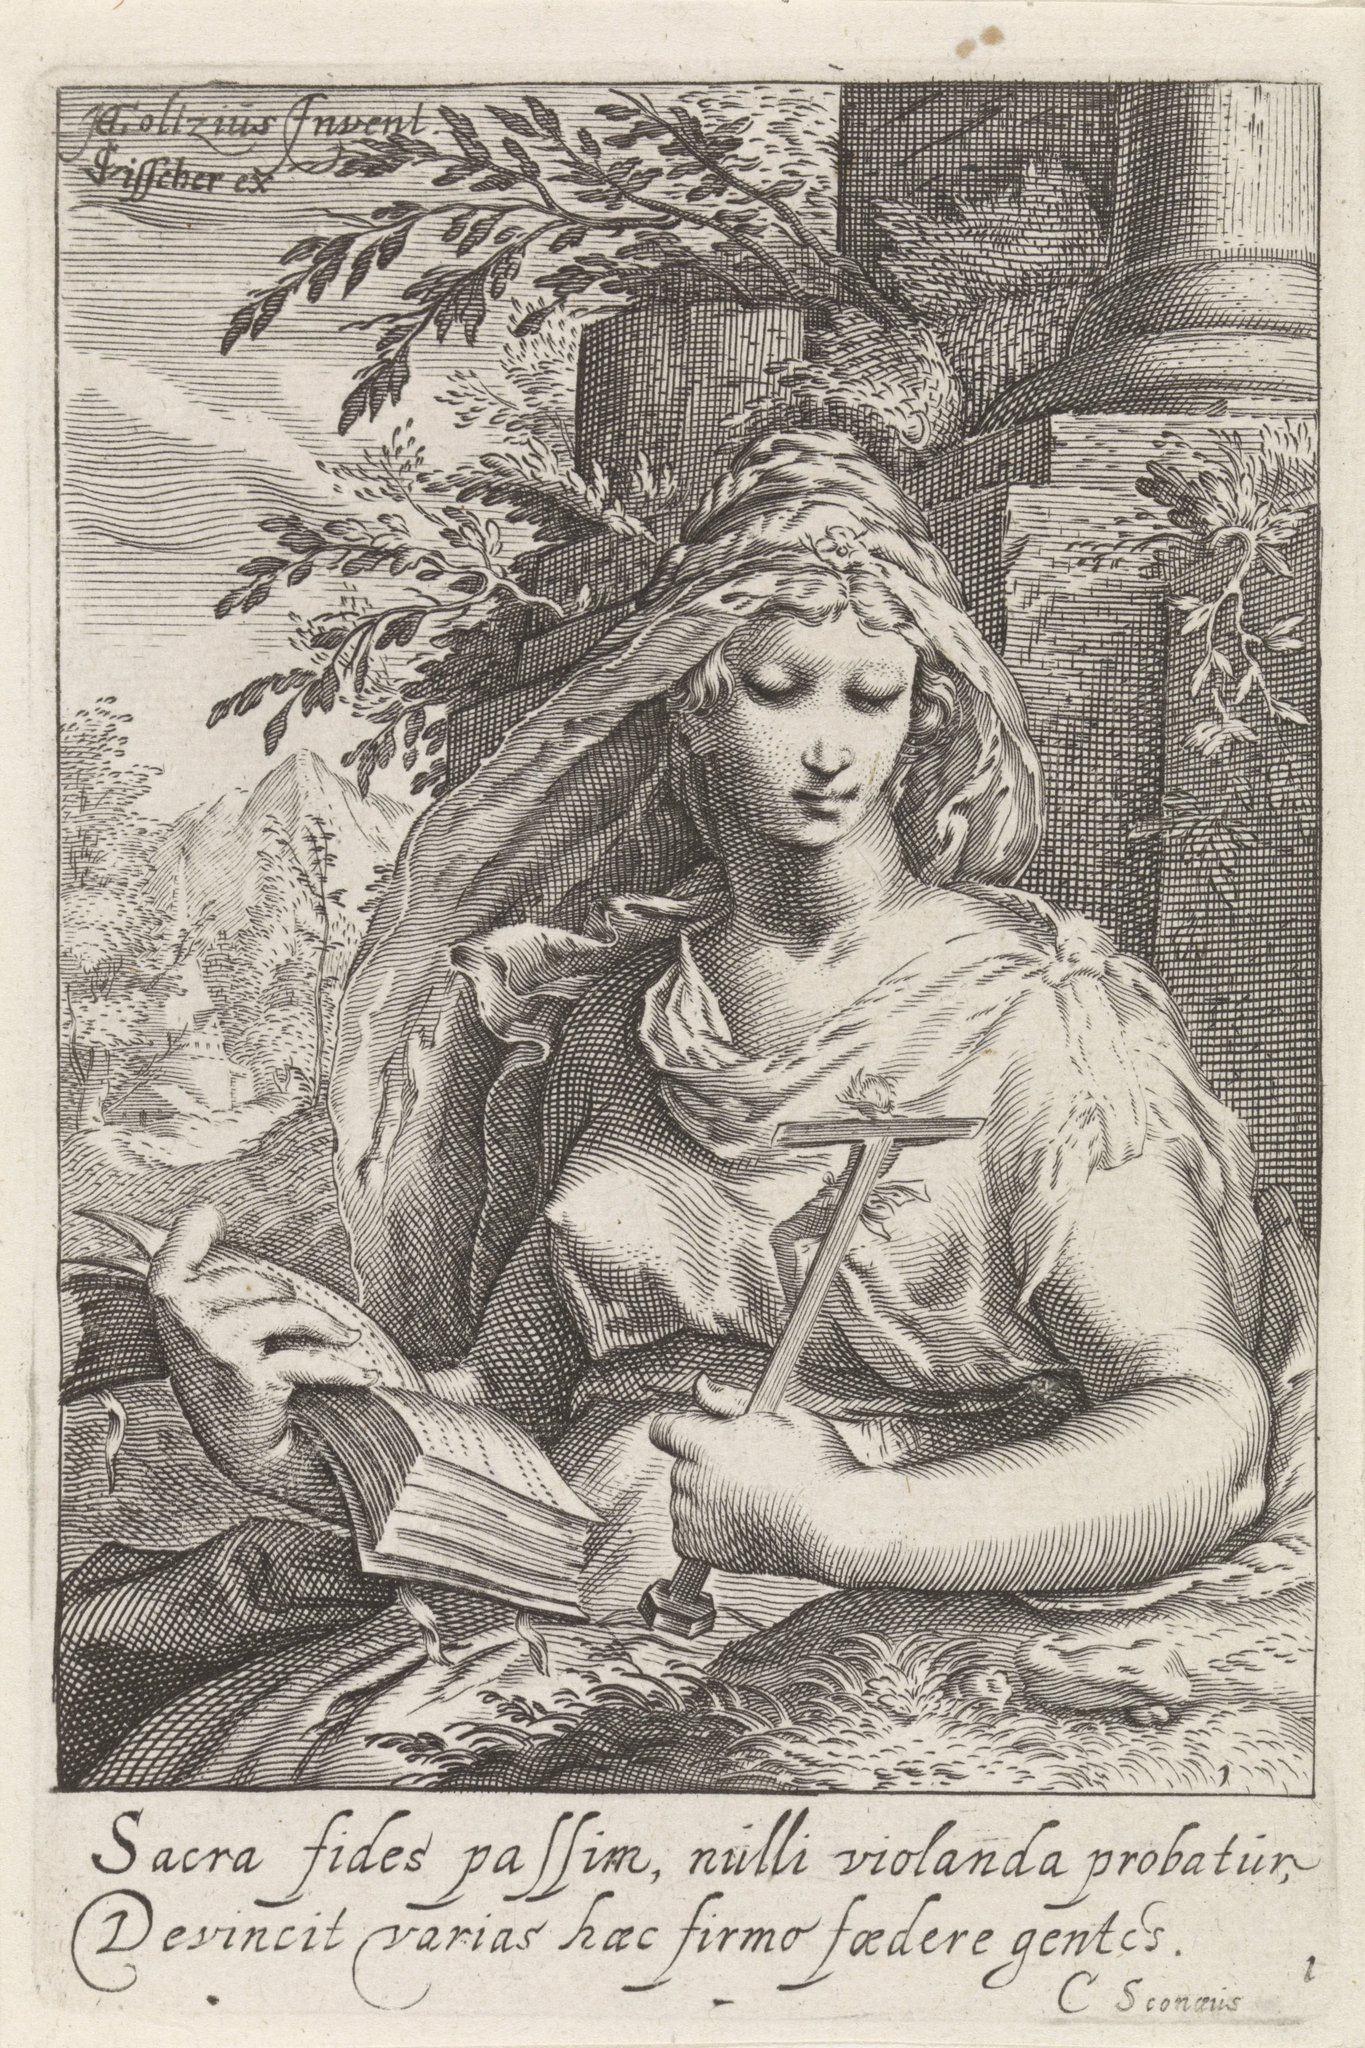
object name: print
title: Geloof (Fides)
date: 1601-1652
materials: paper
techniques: engraving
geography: amsterdam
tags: faith, 'fides'; 'fede', 'fede catholica', 'fede christiana', 'fede christiana catholica' (ripa) ~ one of the three theological virtues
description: Een vrouwenfiguur met een crucifix en een bijbel in een landschap als personificatie van het geloof (fides).